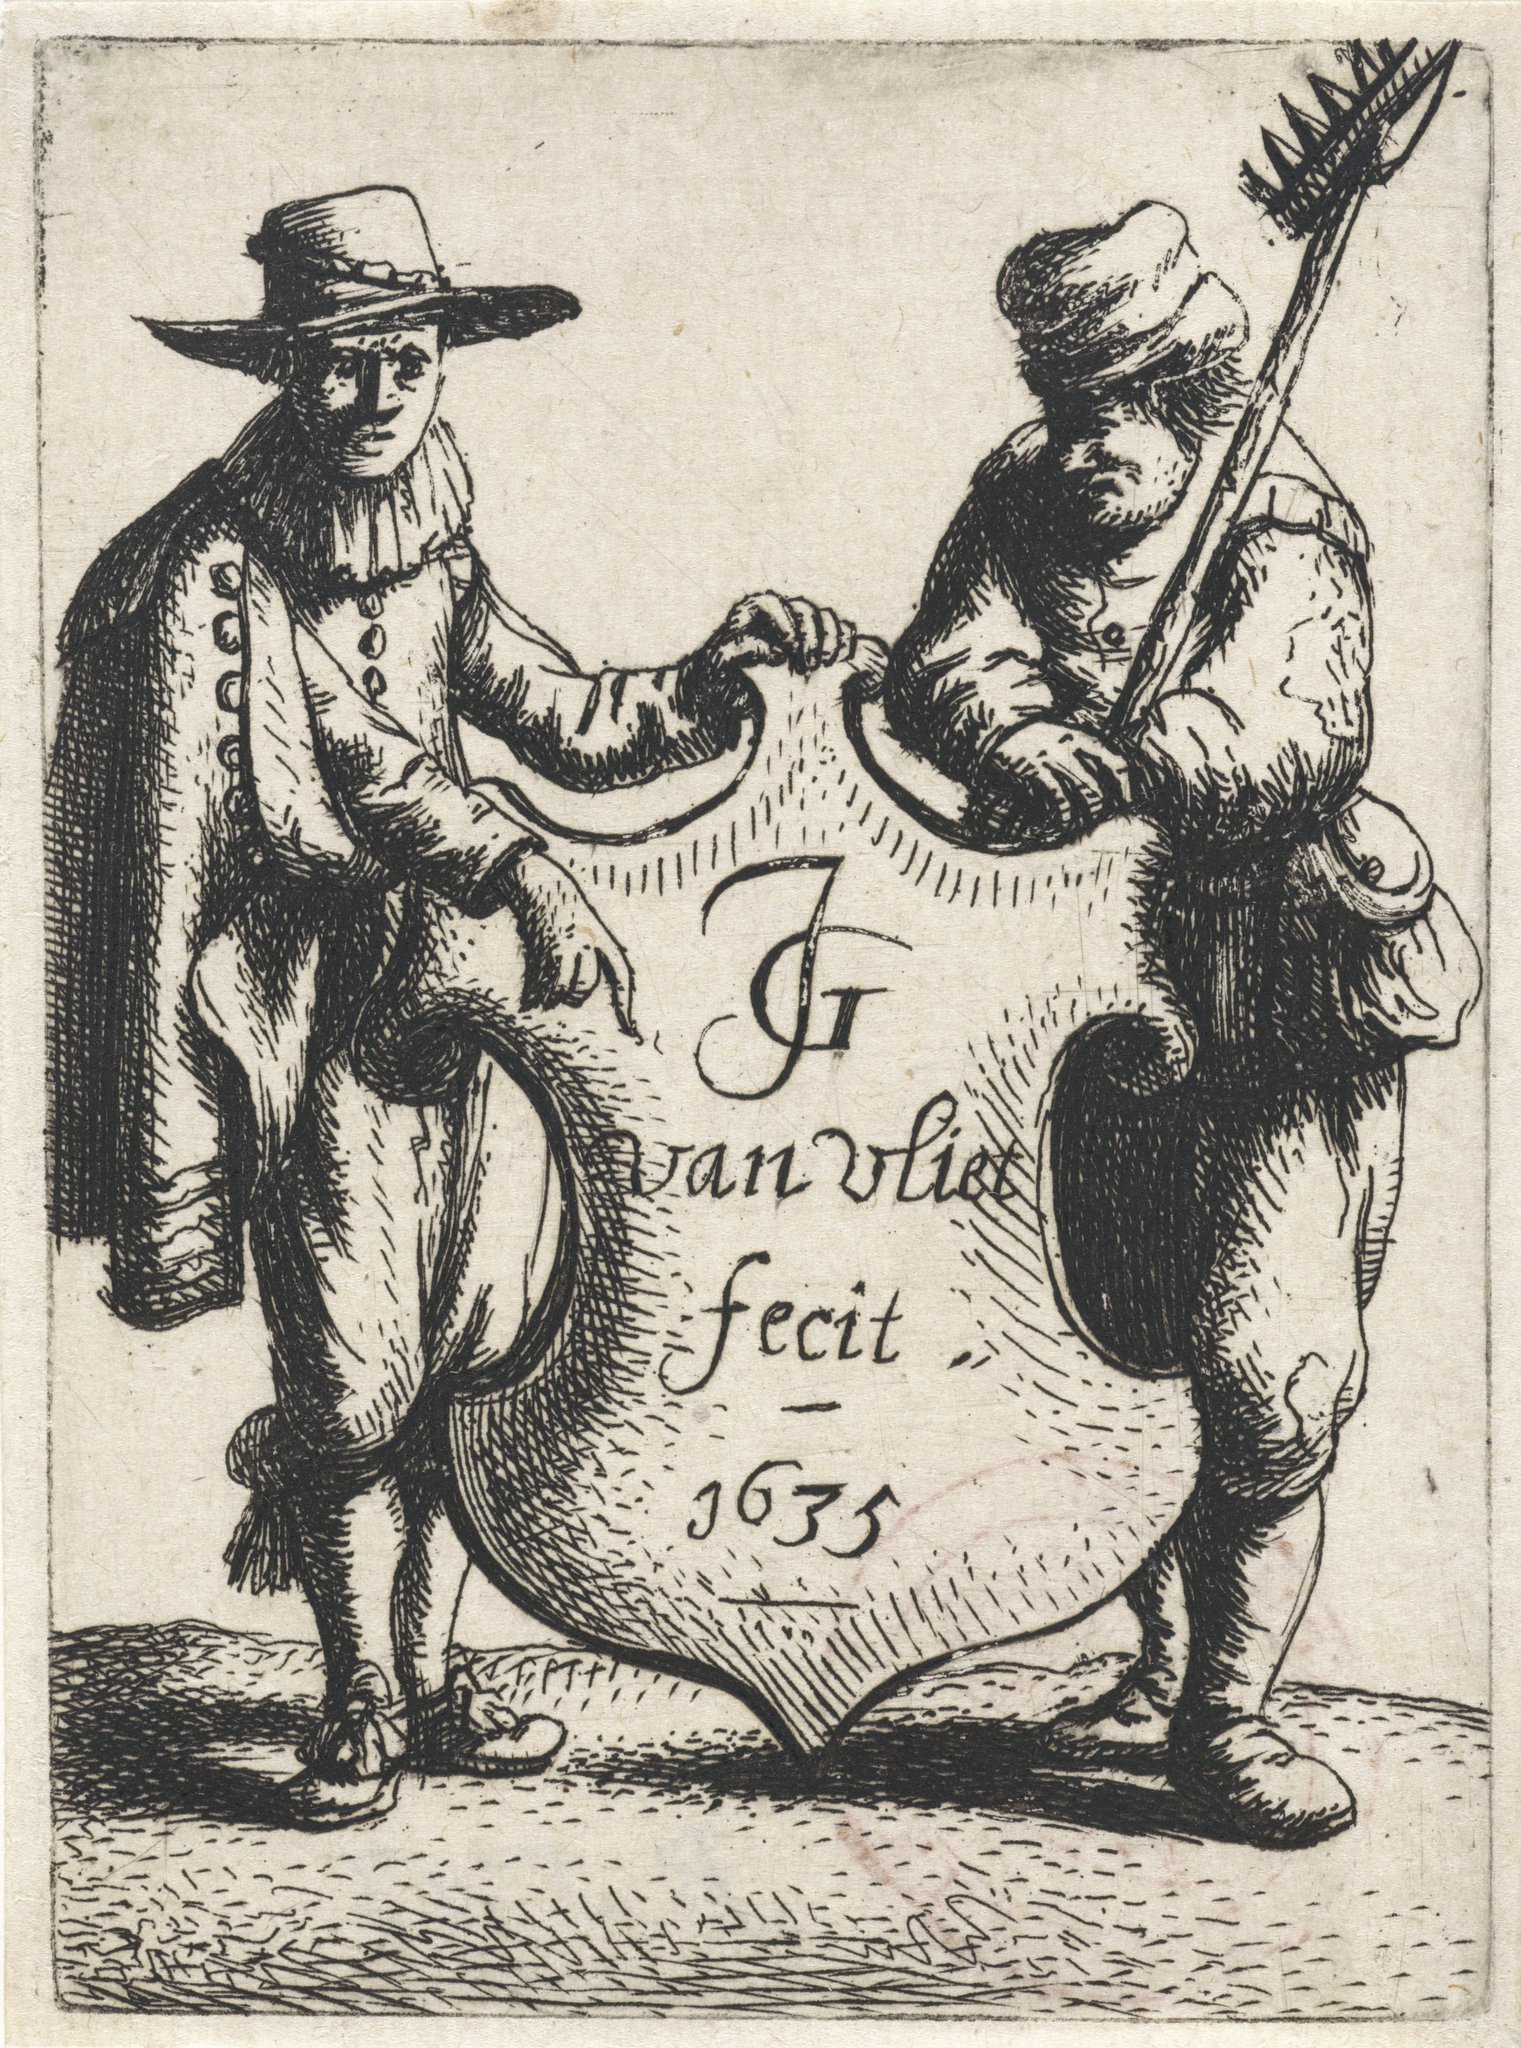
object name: titelprent, frontispice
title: Staande figuren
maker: jan gillisz. van vliet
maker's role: draughtsman, painter, print maker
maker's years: 1600-1668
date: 1635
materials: paper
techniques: etching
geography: leiden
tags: youth, adolescent, handicrafts ~ maintenance and repair (with name of trade or profession)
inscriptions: collector's mark: Lugt 240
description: Een elegant geklede jonge man en een schoorsteenveger aan weerszijden van een wapenschild.